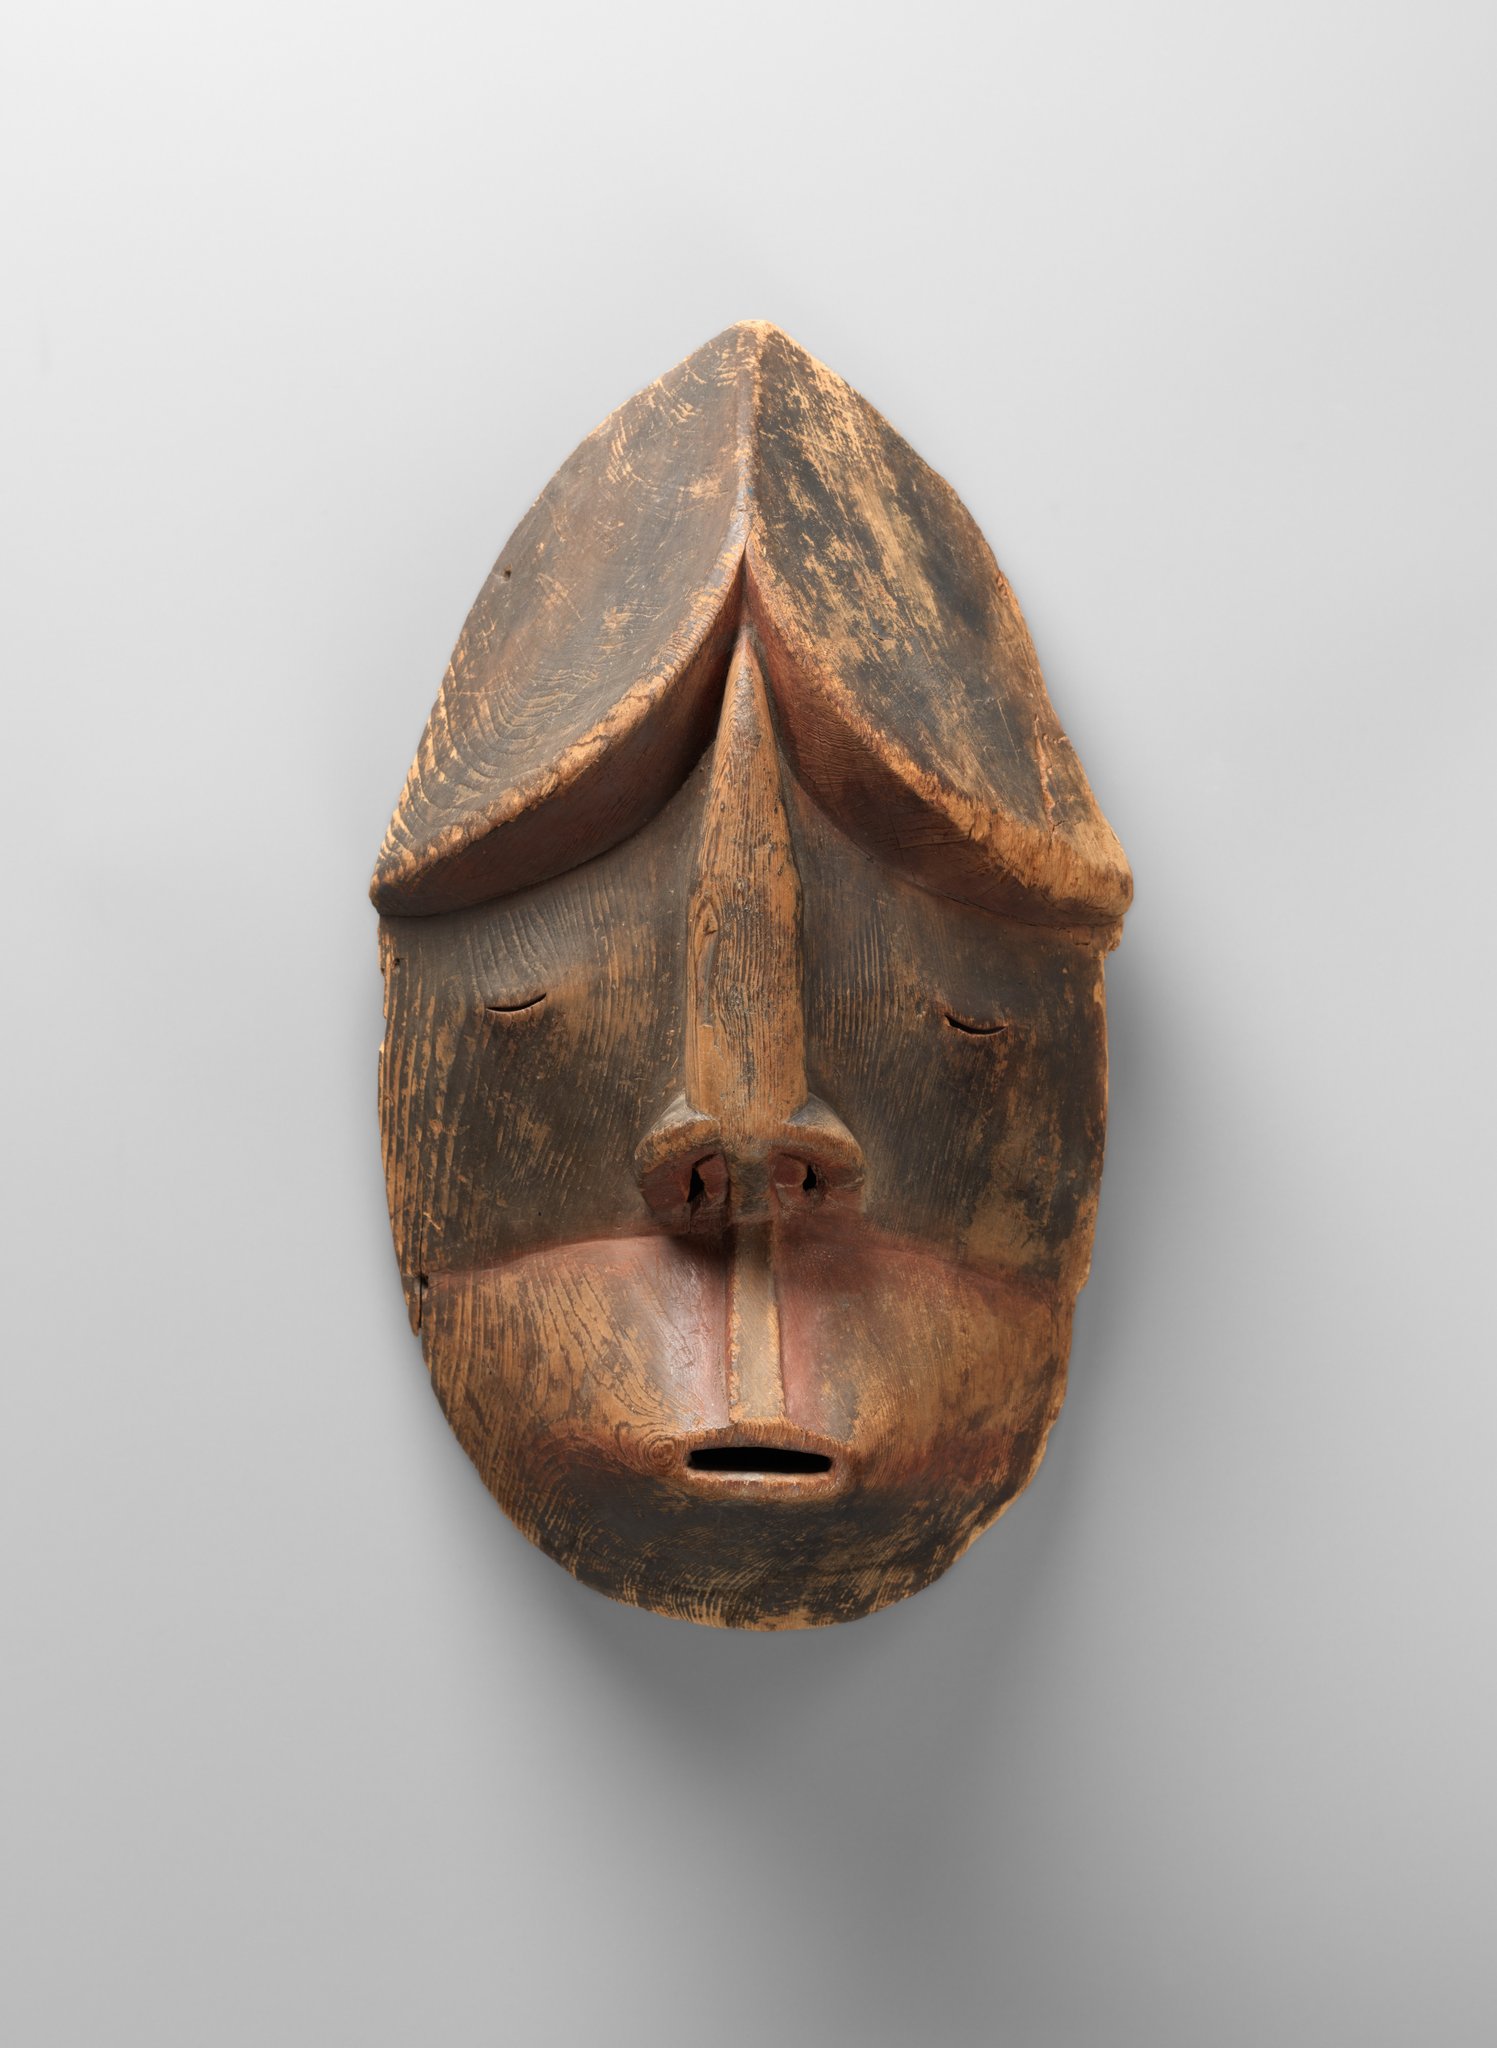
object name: mask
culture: alutiiq or sugpiaq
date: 1870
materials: pigment, wood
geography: united states